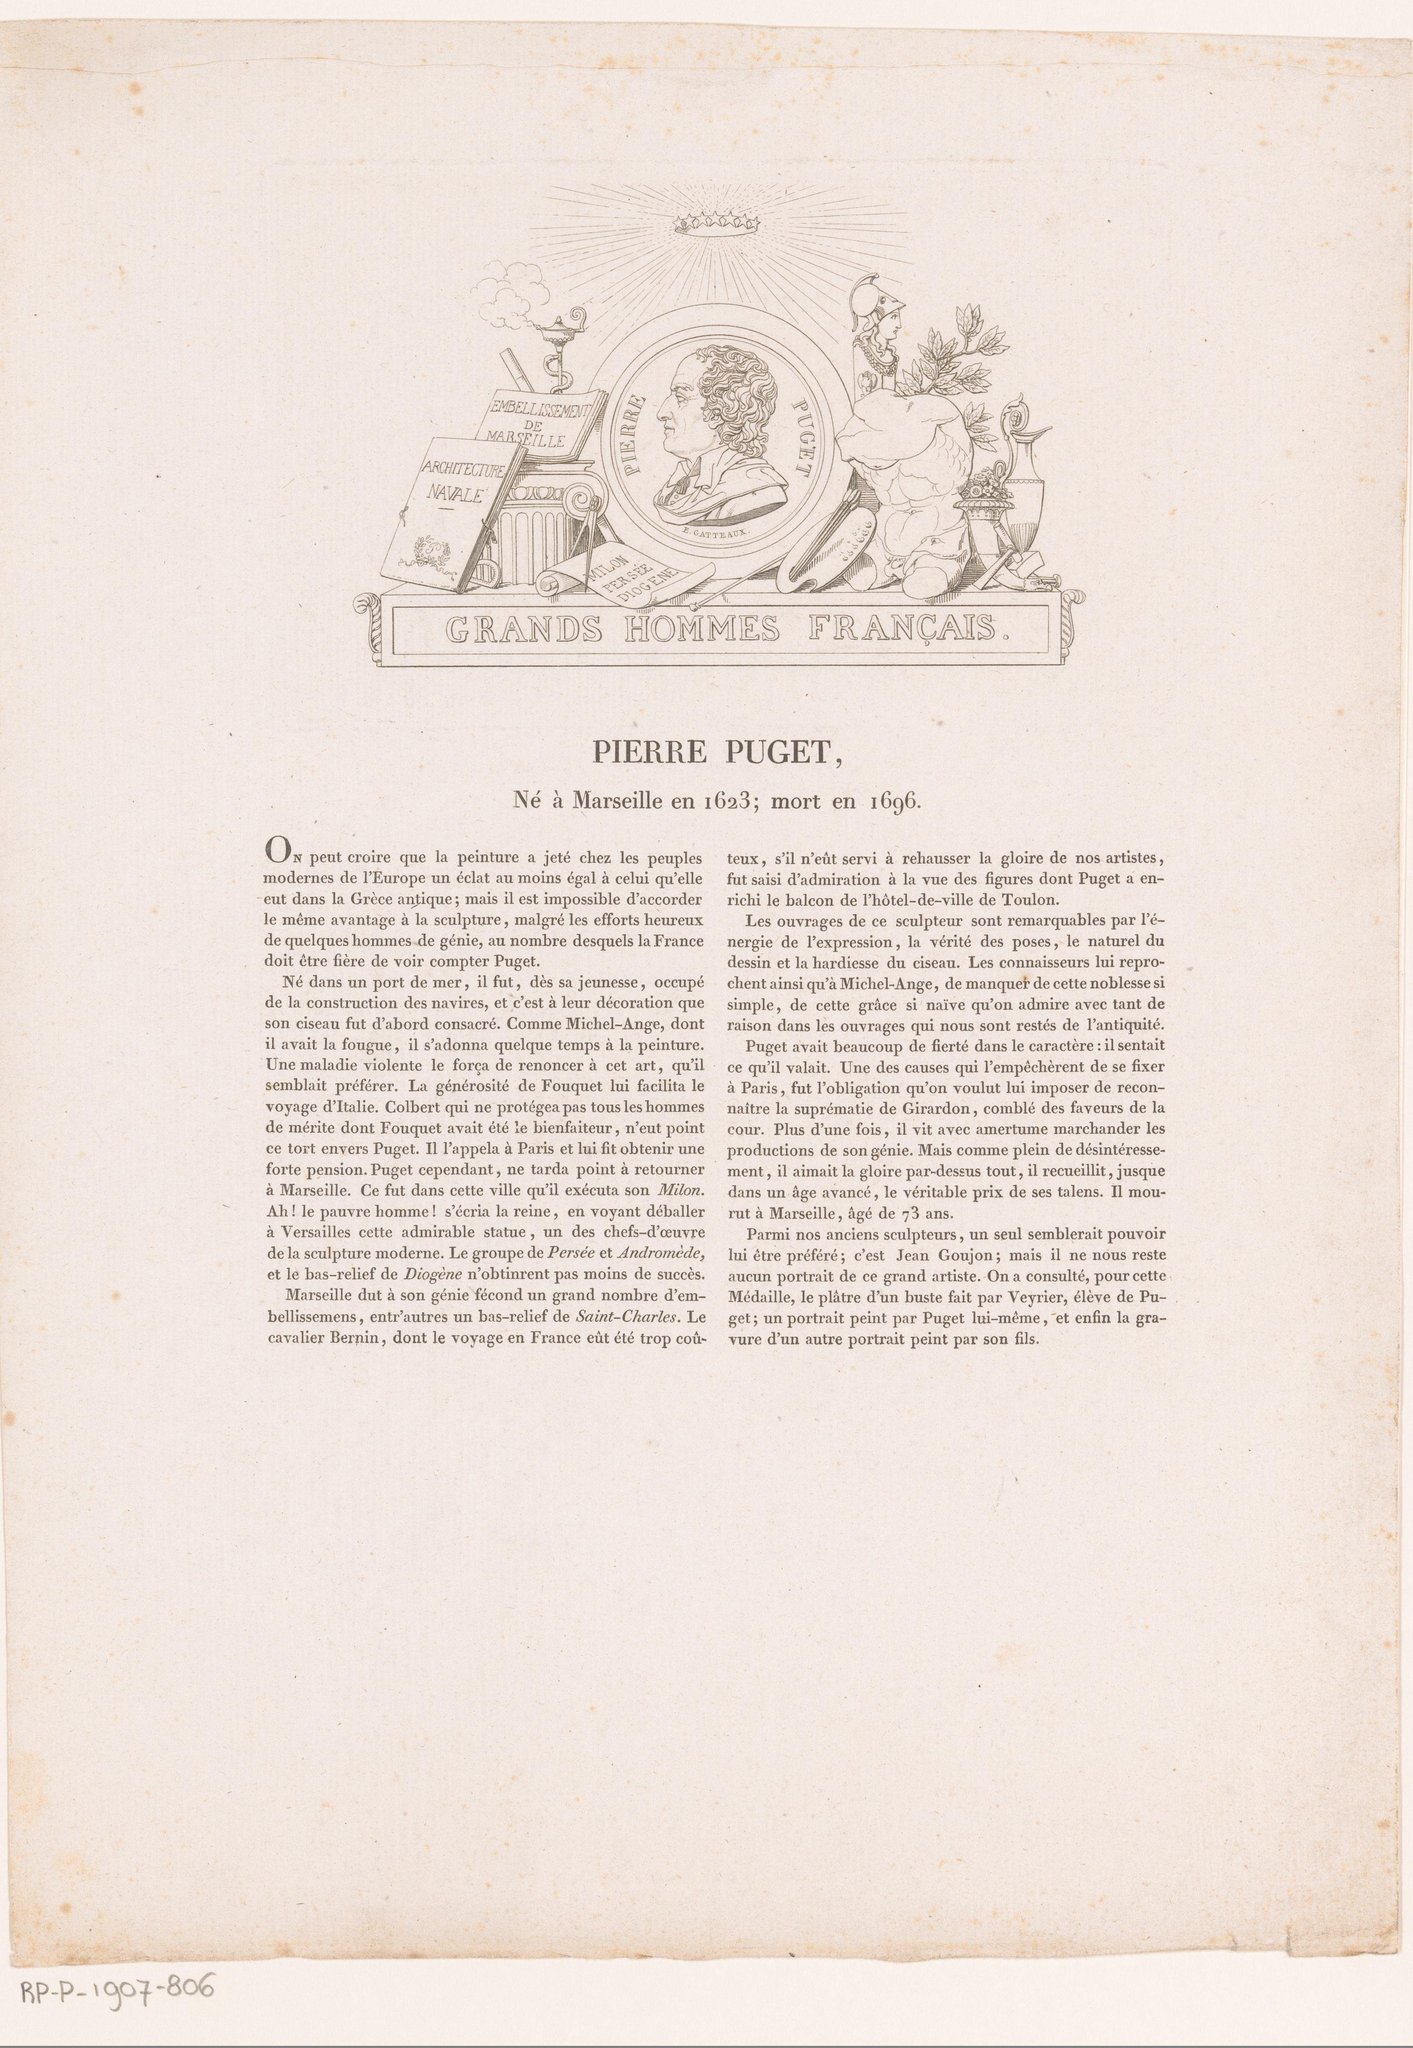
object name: print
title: Galerie métallique des grands hommes français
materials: paper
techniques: etching, letterpress printing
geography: paris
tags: painter, engineer, portrait, self-portrait of sculptor, historical persons, portrait, self-portrait of architect, portrait, self-portrait of painter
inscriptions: collector's mark: Lugt 2228